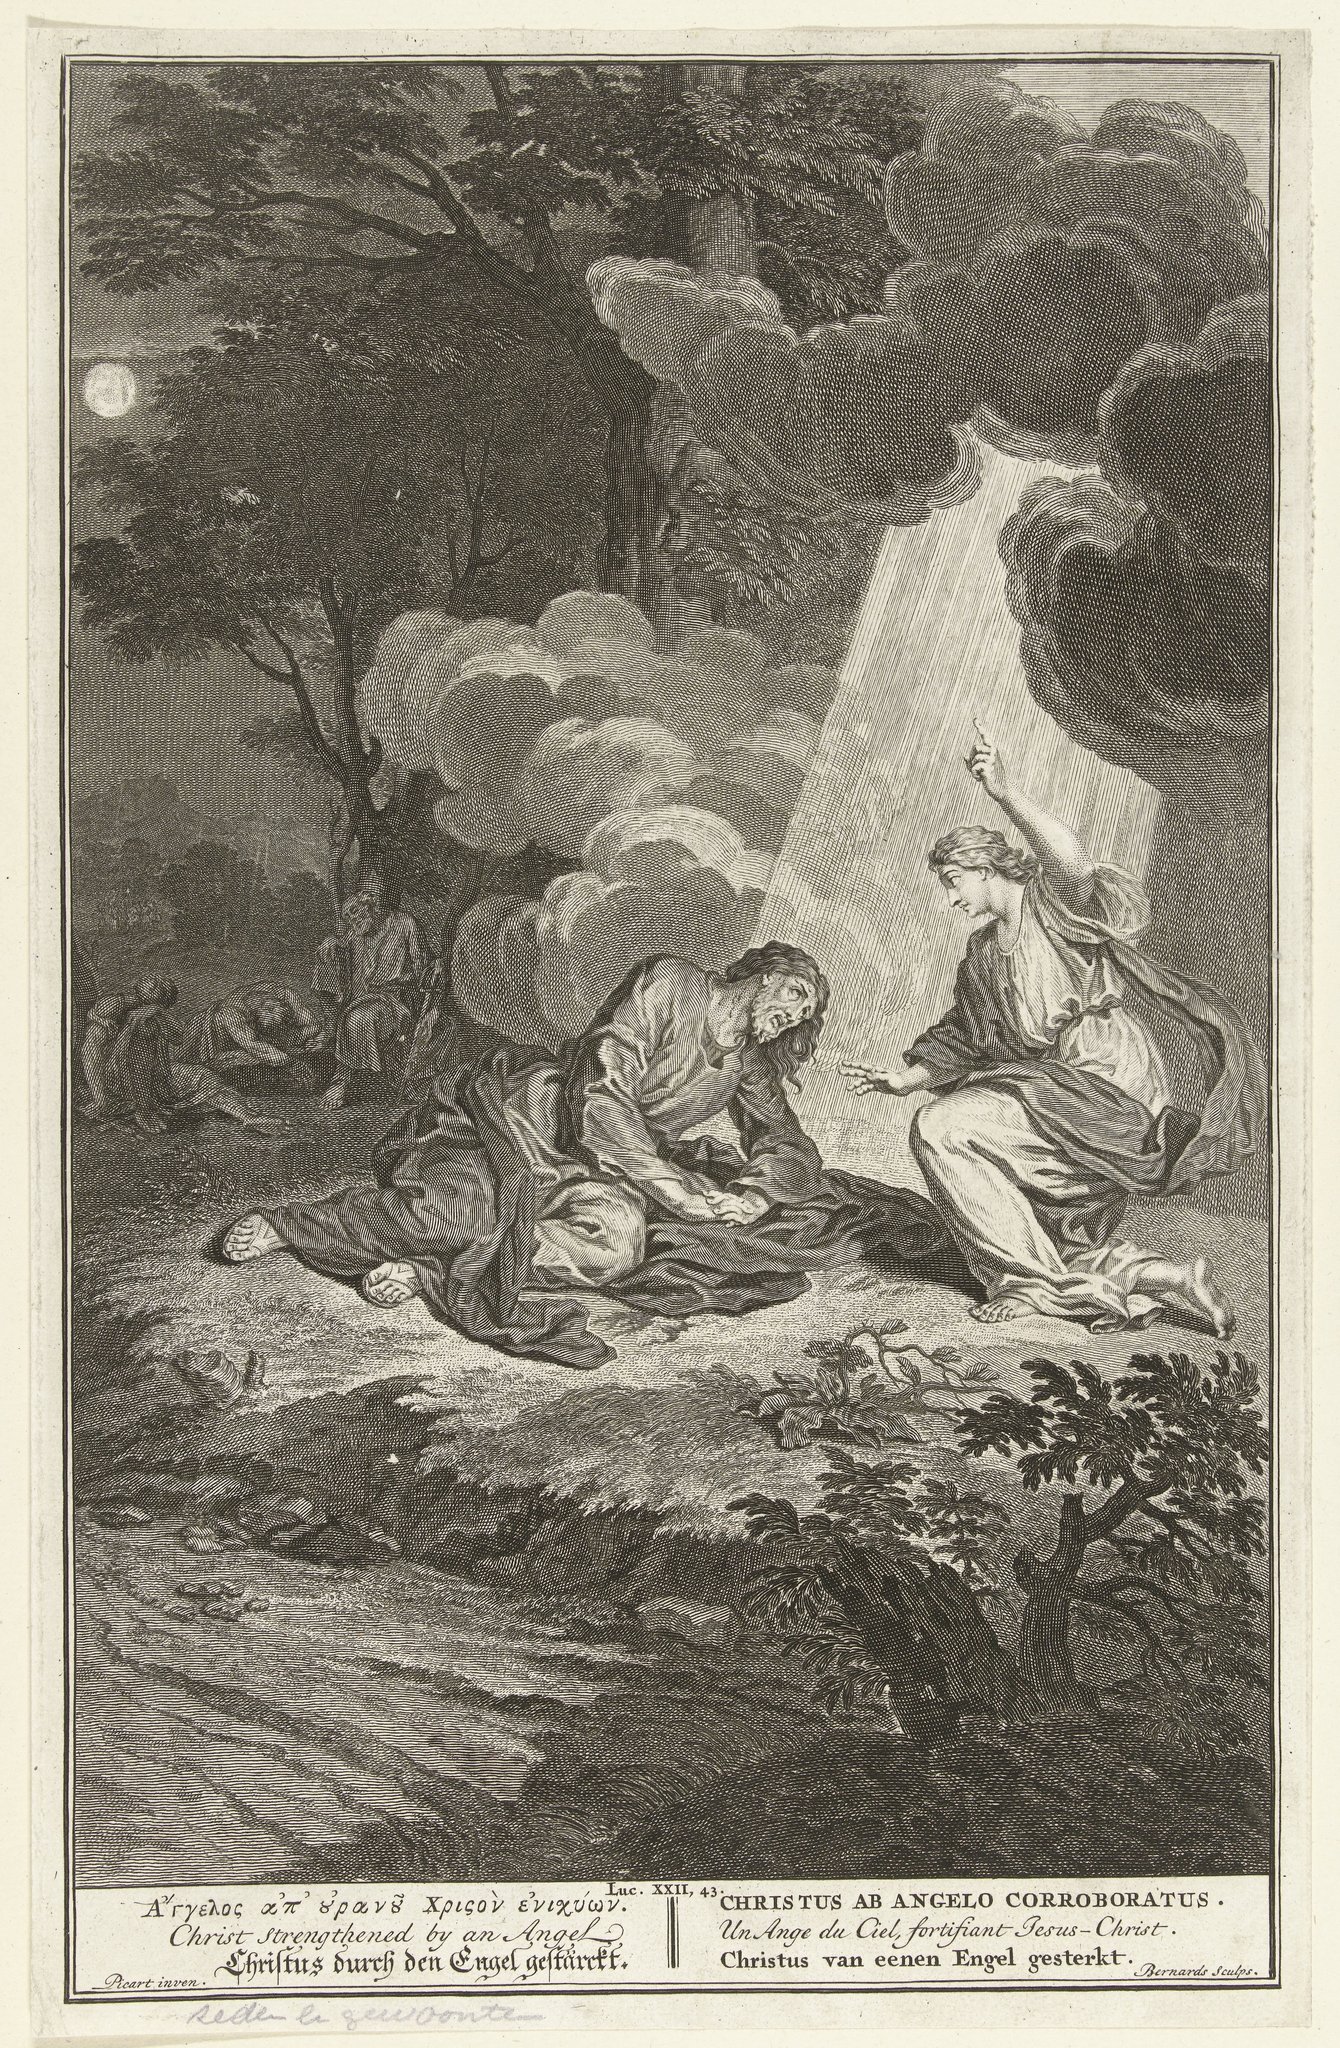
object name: book illustration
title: Christus van eenen Engel gesterkt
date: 1711-1720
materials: paper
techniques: engraving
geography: amsterdam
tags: agony of christ: to comfort him one or more angels appear to christ with chalice and/or cross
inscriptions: collector's mark: Lugt 2760, collector's mark: Lugt 2228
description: Christus bid voor zijn leerlingen op de olijfberg en wordt door een engel gesteund. Op de achtergrond slapen zijn leerlingen.